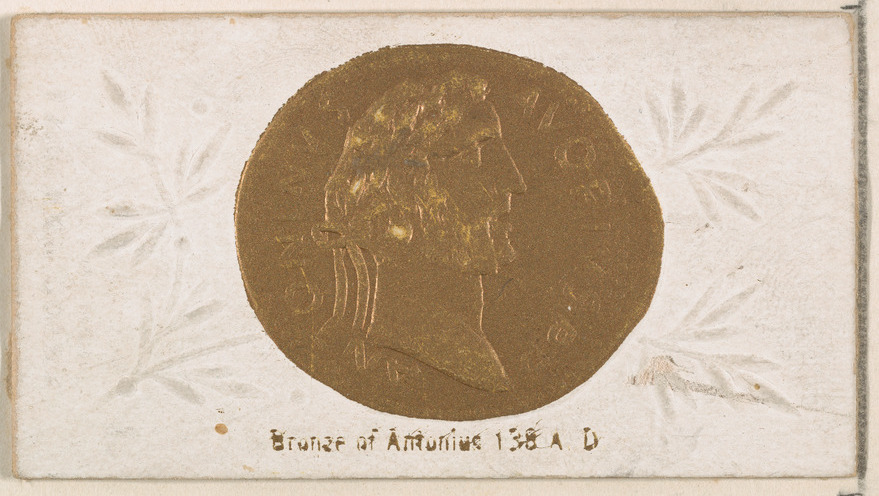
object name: print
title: Bronze of Antonius, 138 A.D., from the Ancient Coins series (N180) issued by Wm. S. Kimball & Co.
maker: william s. kimball & company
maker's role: publisher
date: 1888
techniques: color lithograph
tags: men,coins